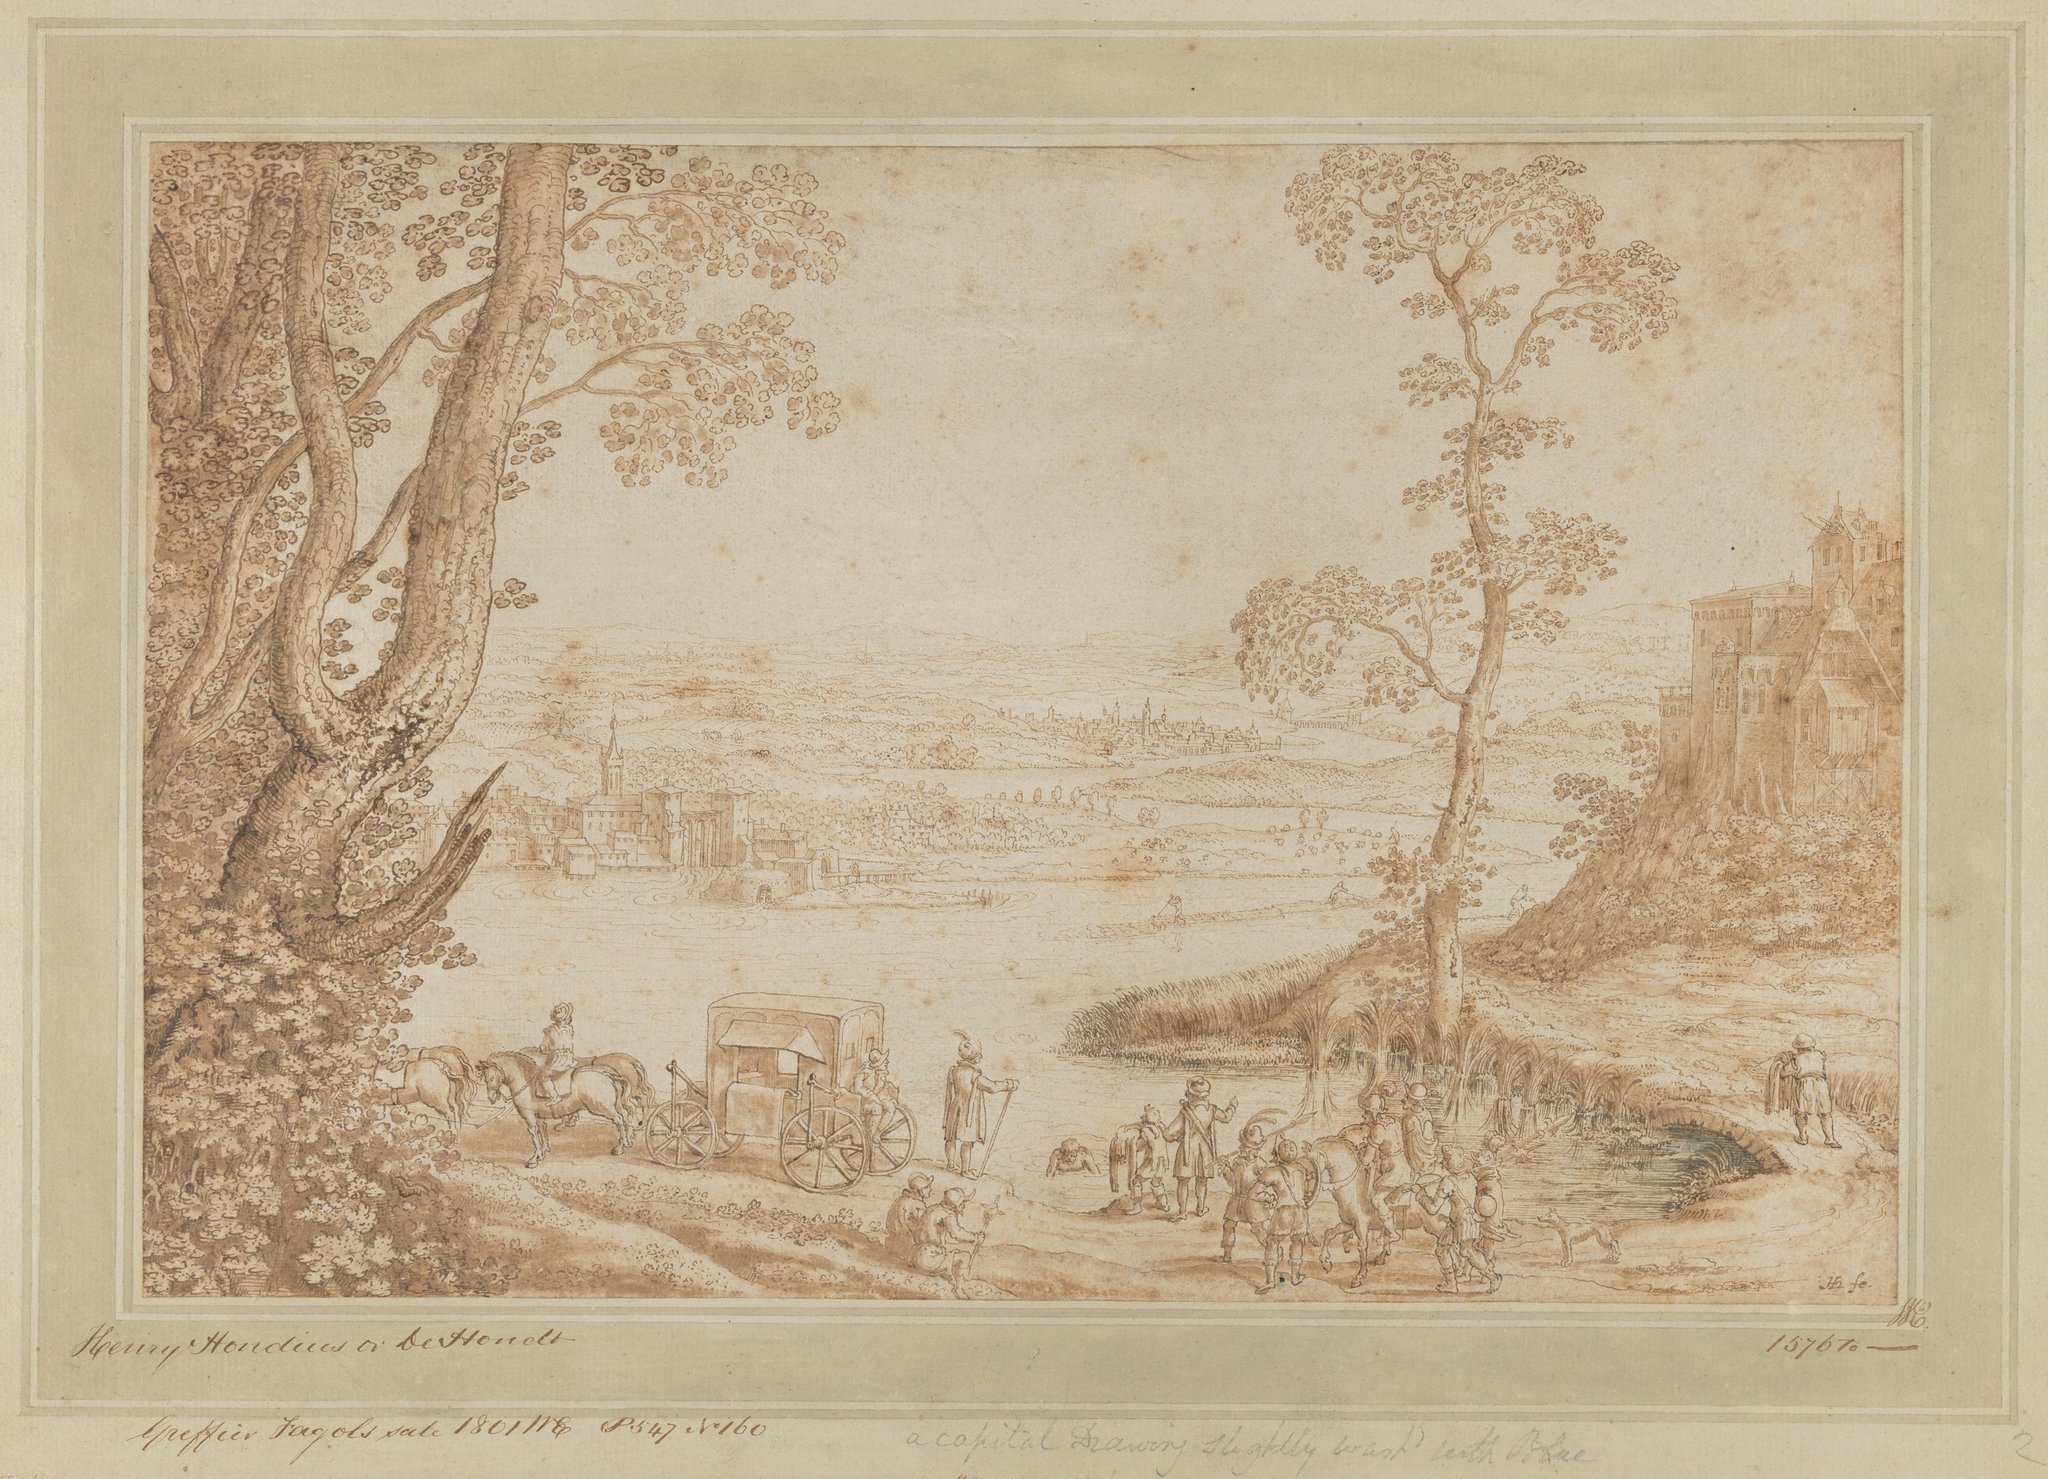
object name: drawing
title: A River Landscape with the Baptism of the Eunuch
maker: hendrick hondius (i)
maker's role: artist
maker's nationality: netherlandish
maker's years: 1573-1650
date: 1605-1625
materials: ink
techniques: pen, wash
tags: rivers,landscapes